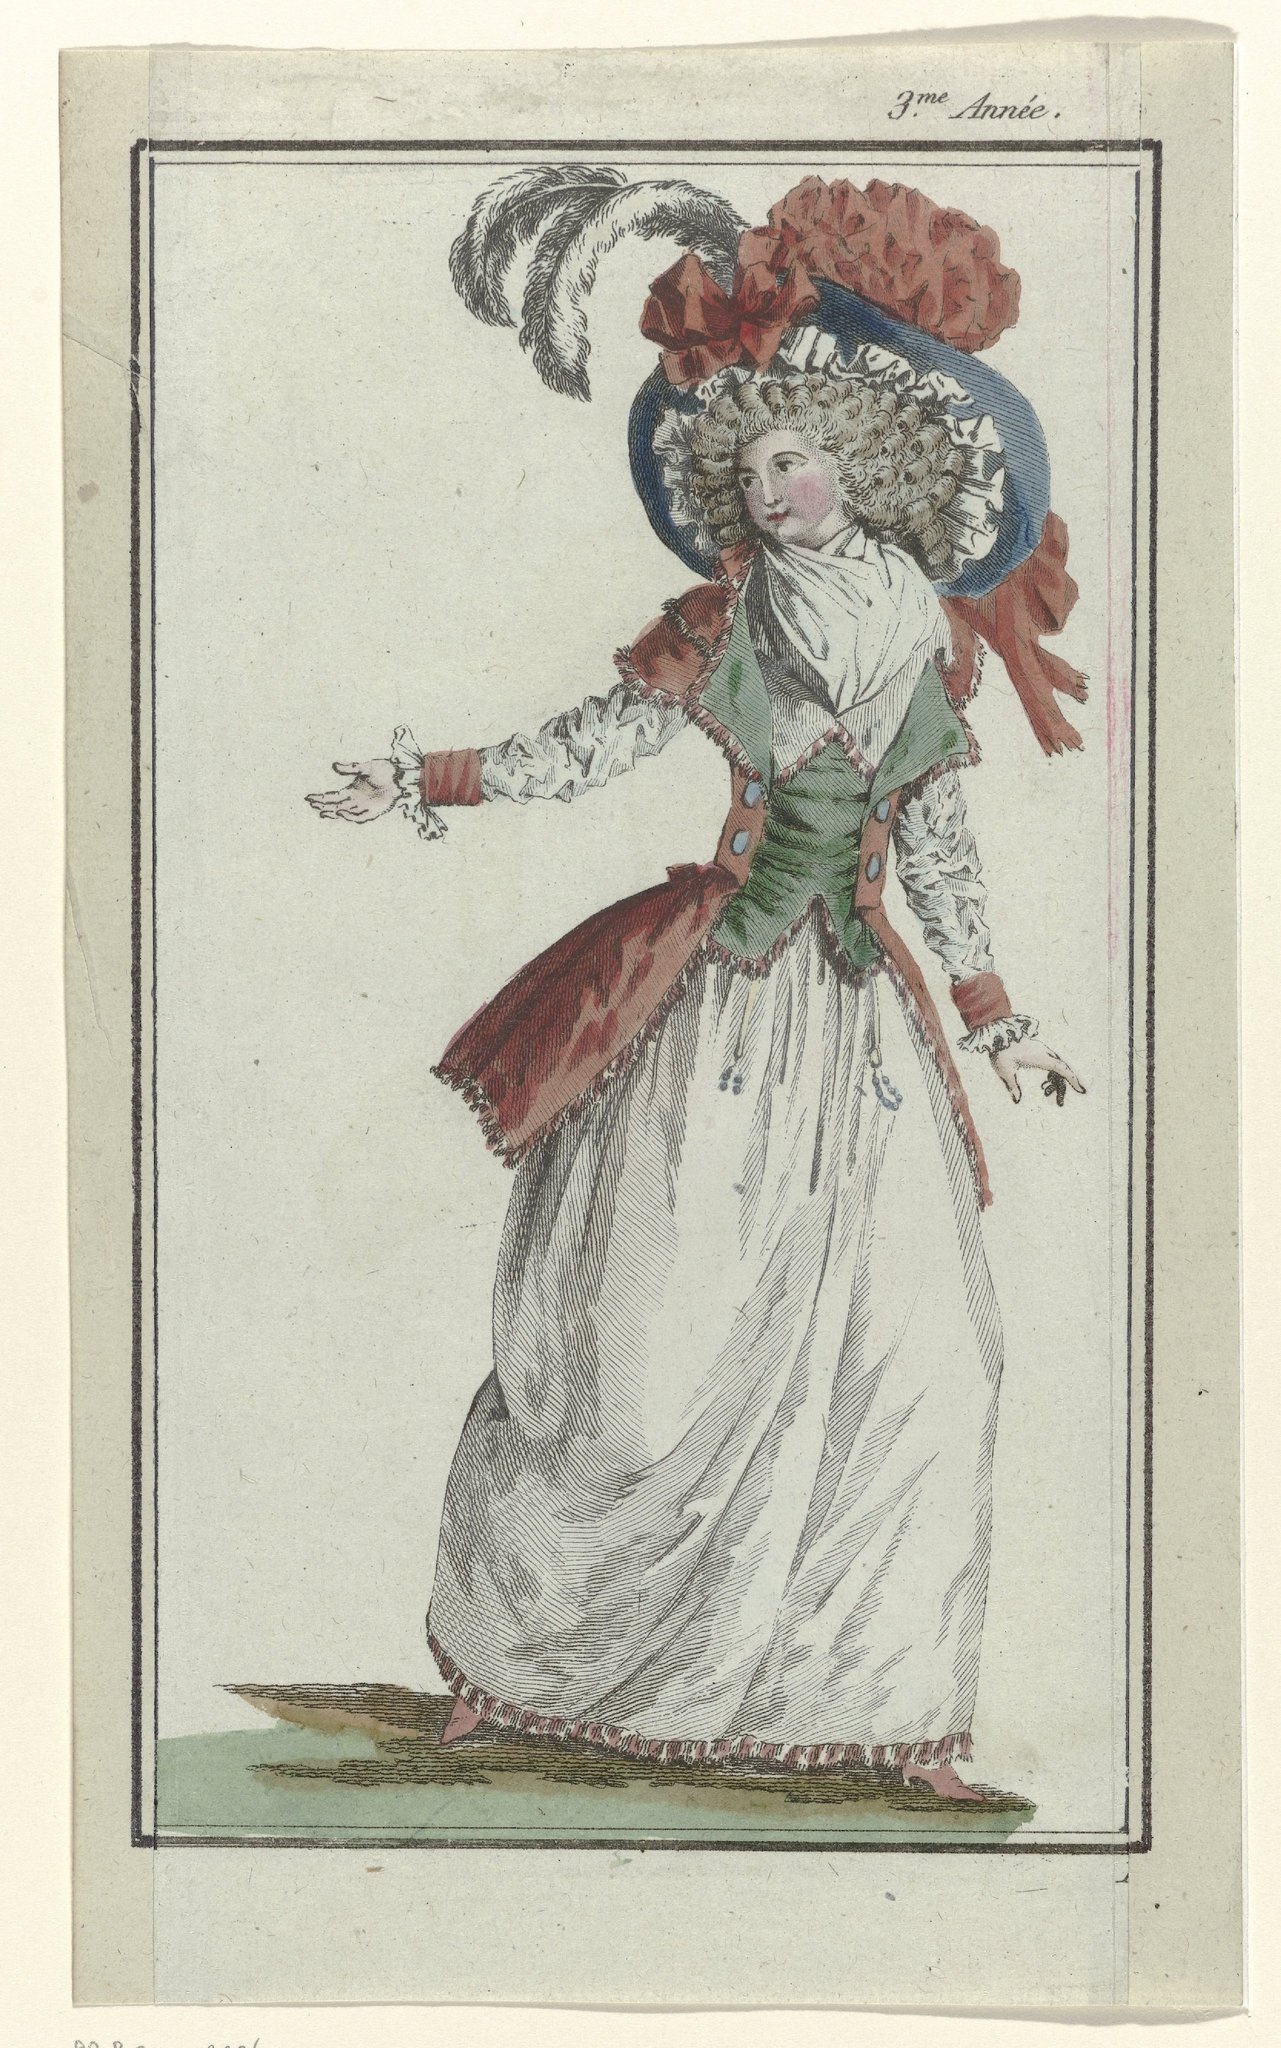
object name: fashion print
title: Magasin des Modes Nouvelles Françaises et Anglaises, 29 février 1788, 3e Année, 11e cahier, Pl. 2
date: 1788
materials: paper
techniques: engraving, hand coloring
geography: paris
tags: clothing for the upper part of the body (caraco) (+ women's clothes), styles of hairdress - aa - ~ women, fashion plates, head-gear: hat (+ women's clothes), skirt (+ women's clothes), piece of clothing covering the breast or décolleté (fichu) (+ women's clothes)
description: Jonge vrouw gekleed in een appelgroen vest en een satijnen caraco met appelgroene revers. Zij draagt een fichu en een rok. Op het gekrulde haar een grote hoed met lint en veren. De prent maakt deel uit van het 11e Cahier, 3e année, uit de serie Magasin des Modes Nouvelles Françaises et Anglaises. De serie bestaat uit 172 modeprenten, uitgegeven door Buisson, Parijs, 20 november 1786 - 21 décembre 1789.